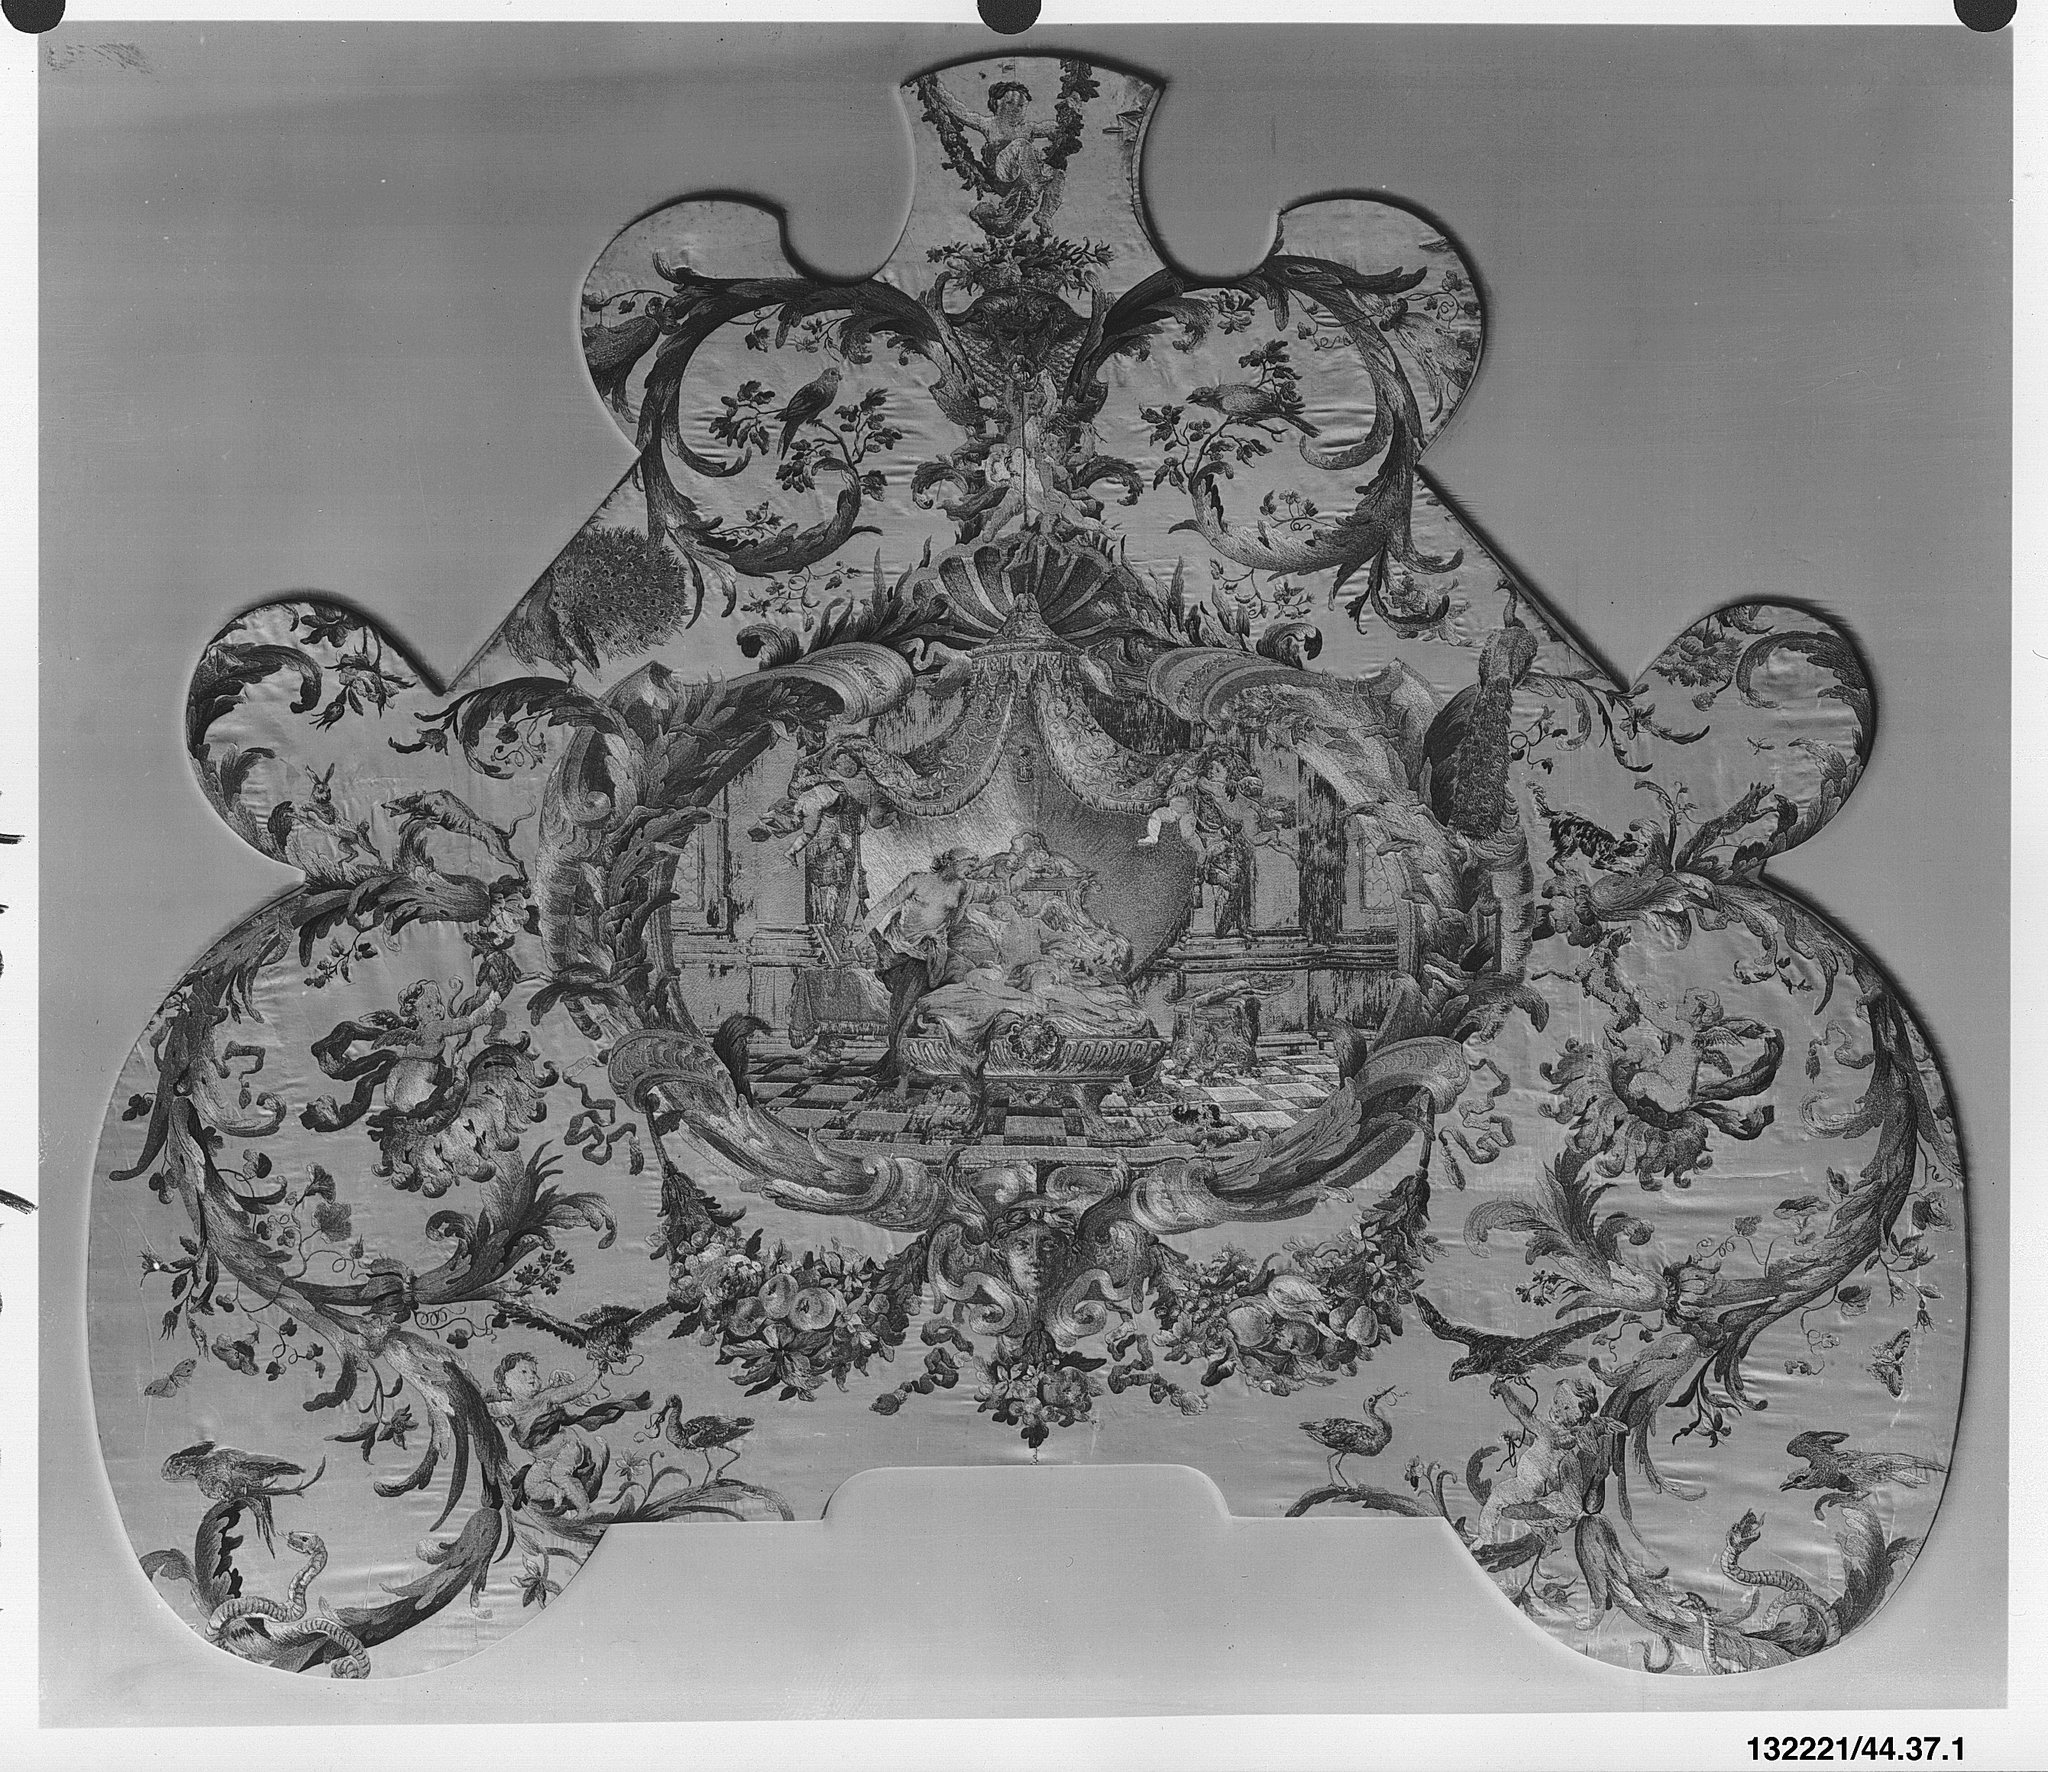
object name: panel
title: Upholstery panel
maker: daniel marot the elder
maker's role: maker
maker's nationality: french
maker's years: 1661-1752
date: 1701-1733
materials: silk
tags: human figures,flowers